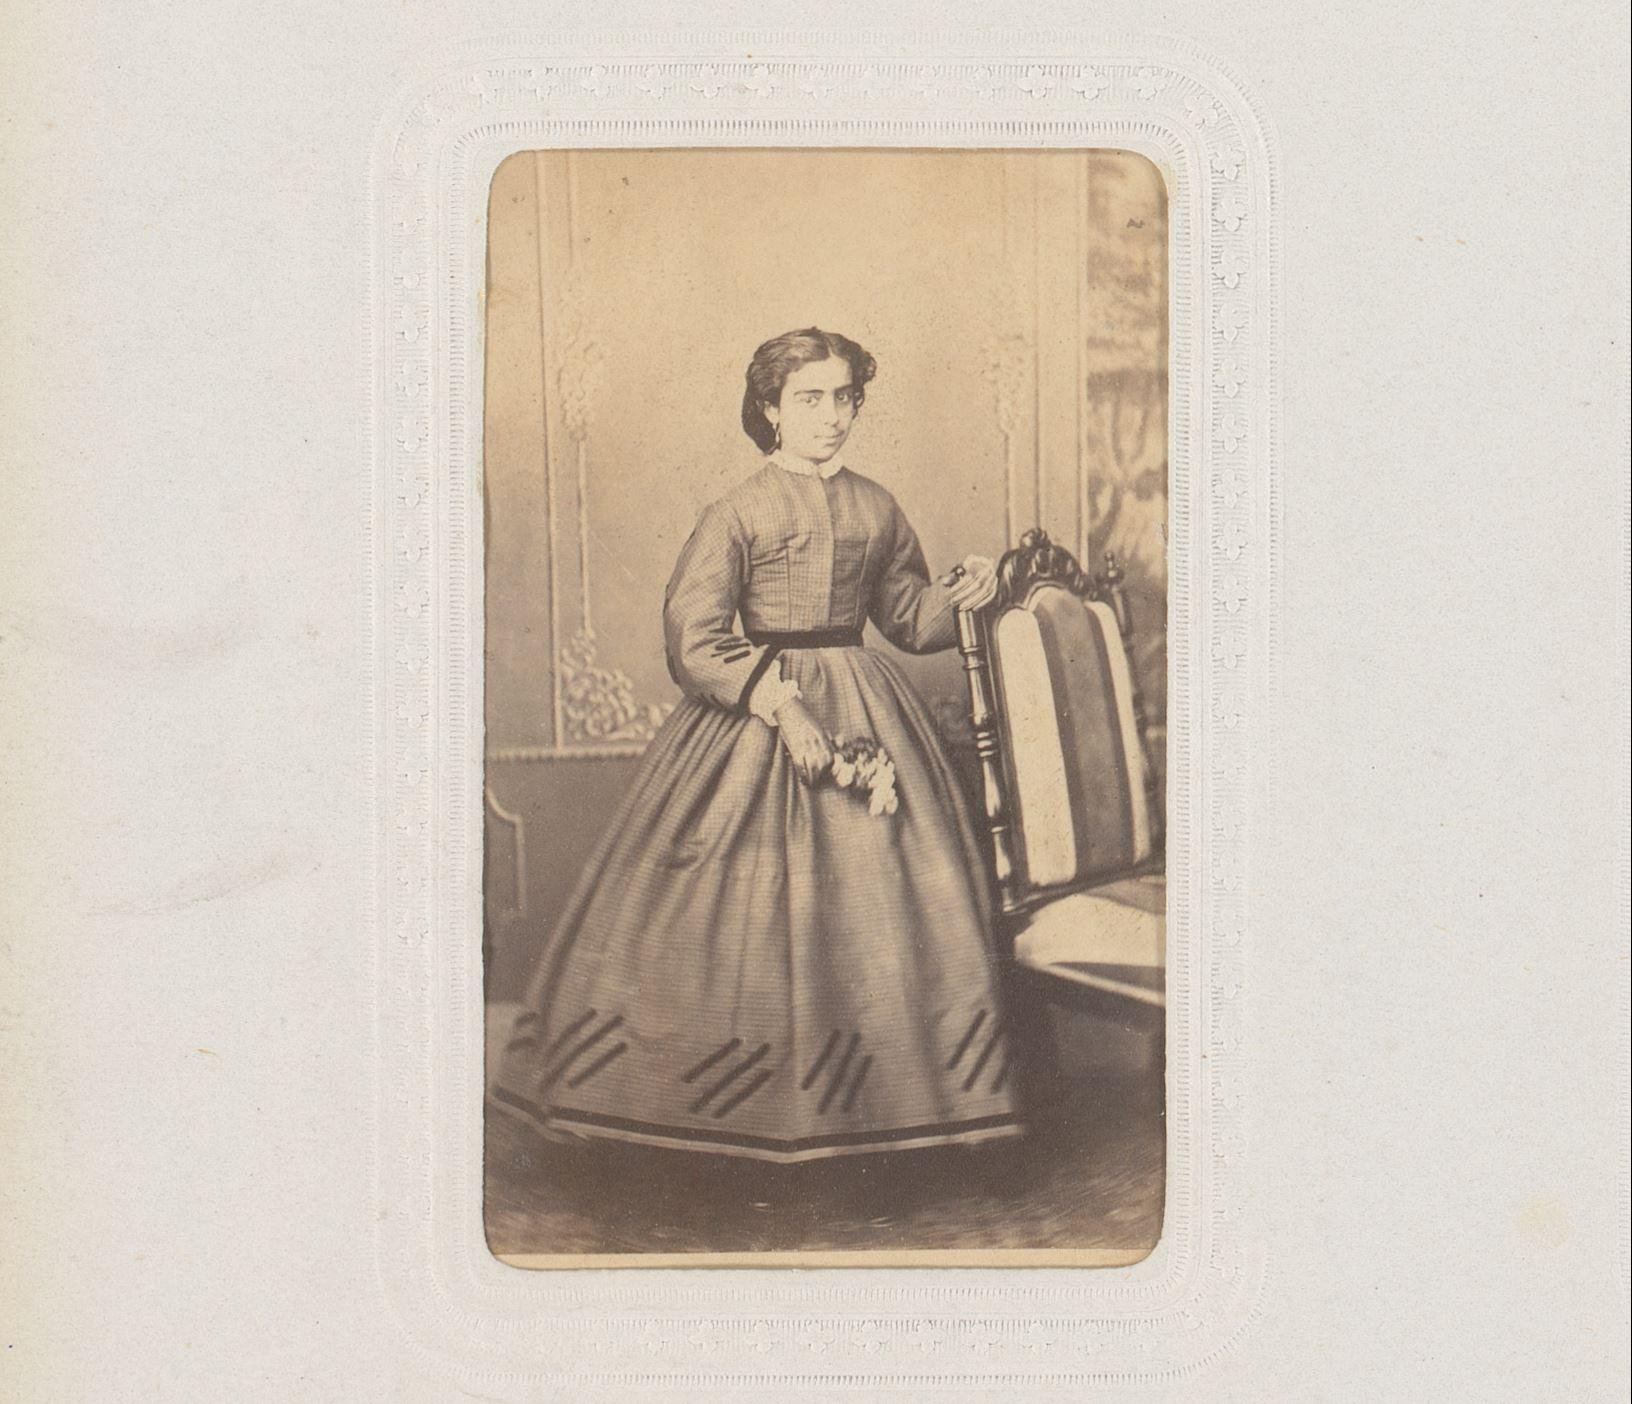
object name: photograph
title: Portret van een vrouw met bloemen, staand bij een stoel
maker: julio planchard y ca.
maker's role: fotograaf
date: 1860-1890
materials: cardboard, photographic support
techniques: albumen print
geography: murcia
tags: historical persons - bb - woman, standing figure - aa - female human figure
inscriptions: inscription: ‘Fotografia/ Julio Planchard y Ca./ Calle de Rillo No. 10/ Murcia’